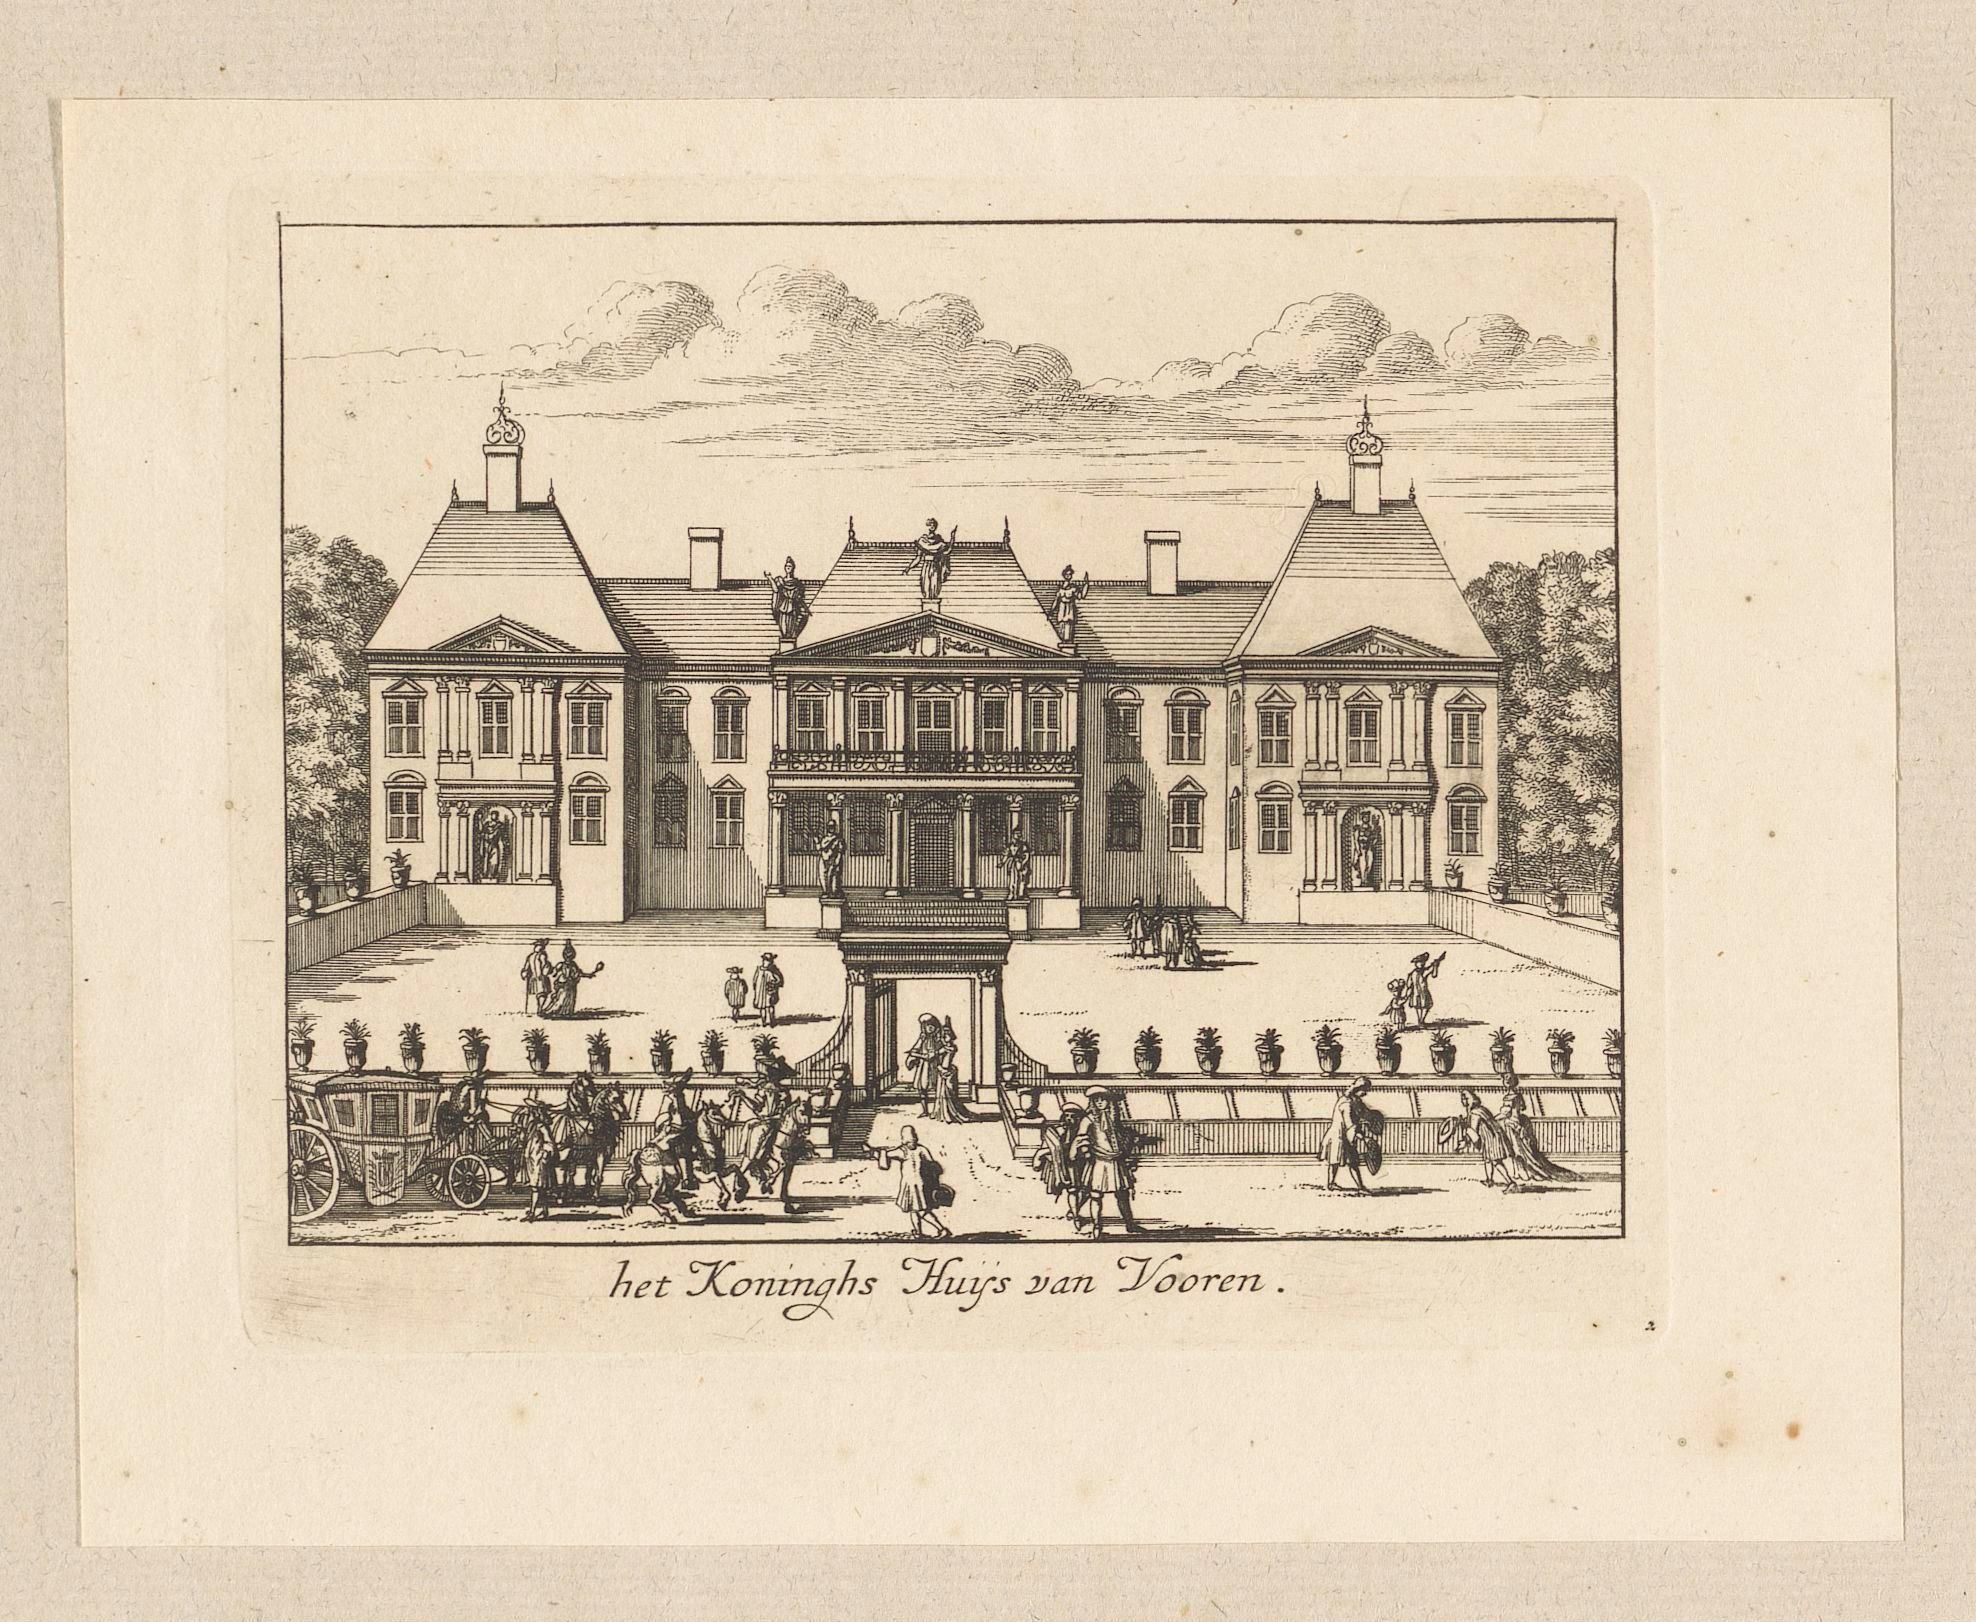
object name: print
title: Zestien prenten van Paleis Honselaarsdijk (Danckerts / Covens en Mortier)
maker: cornelis danckerts (ii)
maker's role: print maker, publisher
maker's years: 1664-1717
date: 1696-1717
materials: paper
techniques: etching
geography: amsterdam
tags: palace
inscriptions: collector's mark: Lugt 2233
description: De voorgevel van Paleis Honselaarsdijk met op het plein voor het paleis groepjes wandelaars. Rechtsonder genummerd: 2. Prent uit een serie van zestien prenten van Paleis Honselaarsdijk.